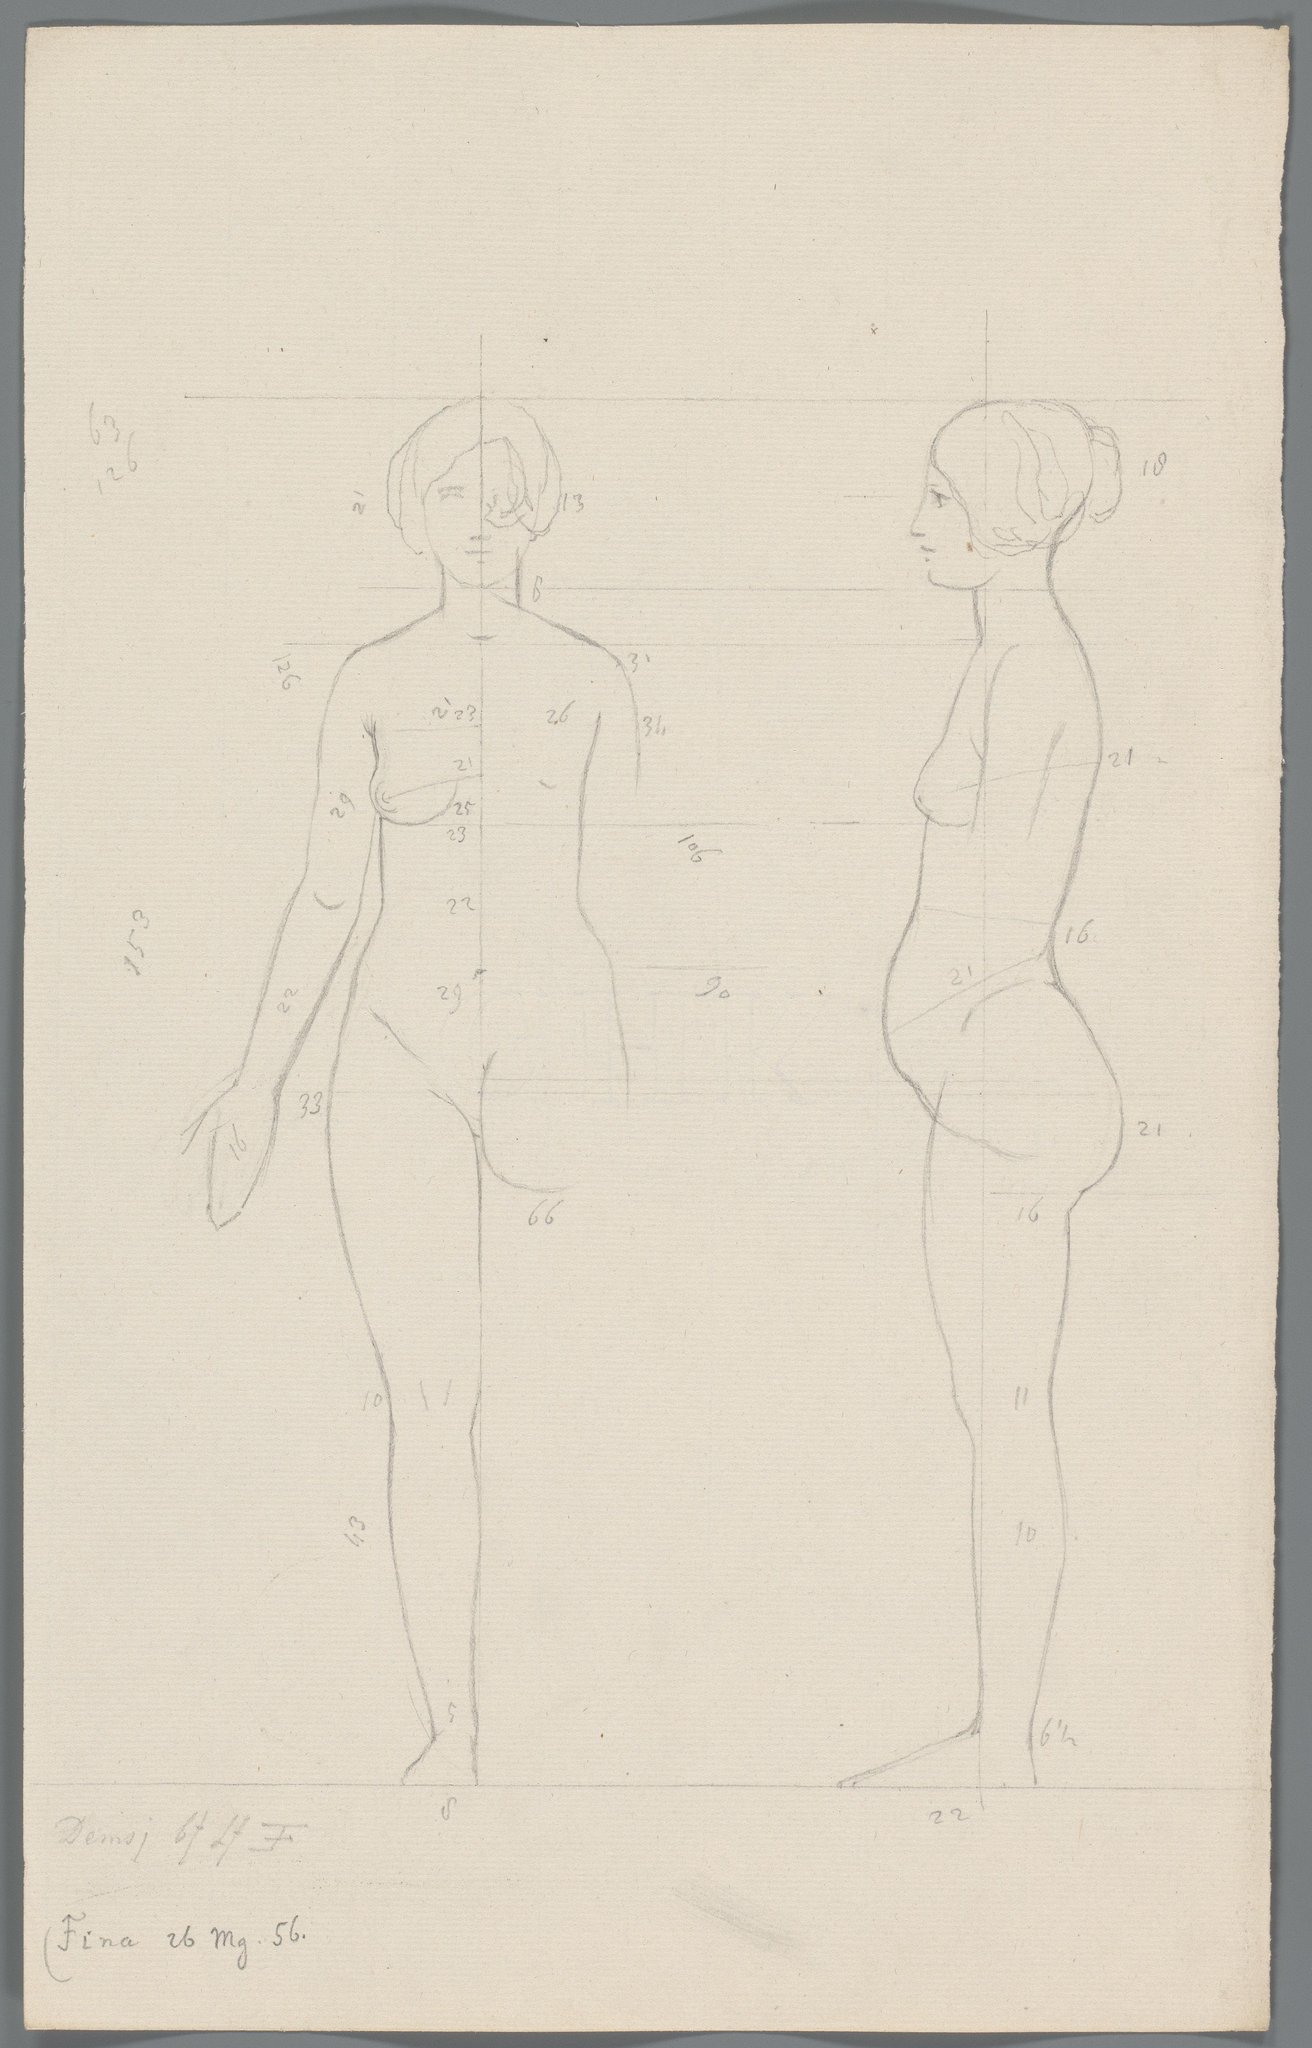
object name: drawing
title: Proportiestudie van een vrouw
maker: jacobus everhardus josephus van den berg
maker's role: draughtsman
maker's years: 1802-1861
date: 1856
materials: paper, pencil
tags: standing figure (canon, proportions) - aa - female human figure, anatomy (non-medical) - aa - female human figure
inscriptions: inscription: ‘Demsj bf lf EF/ Fina 26 mg 56.’